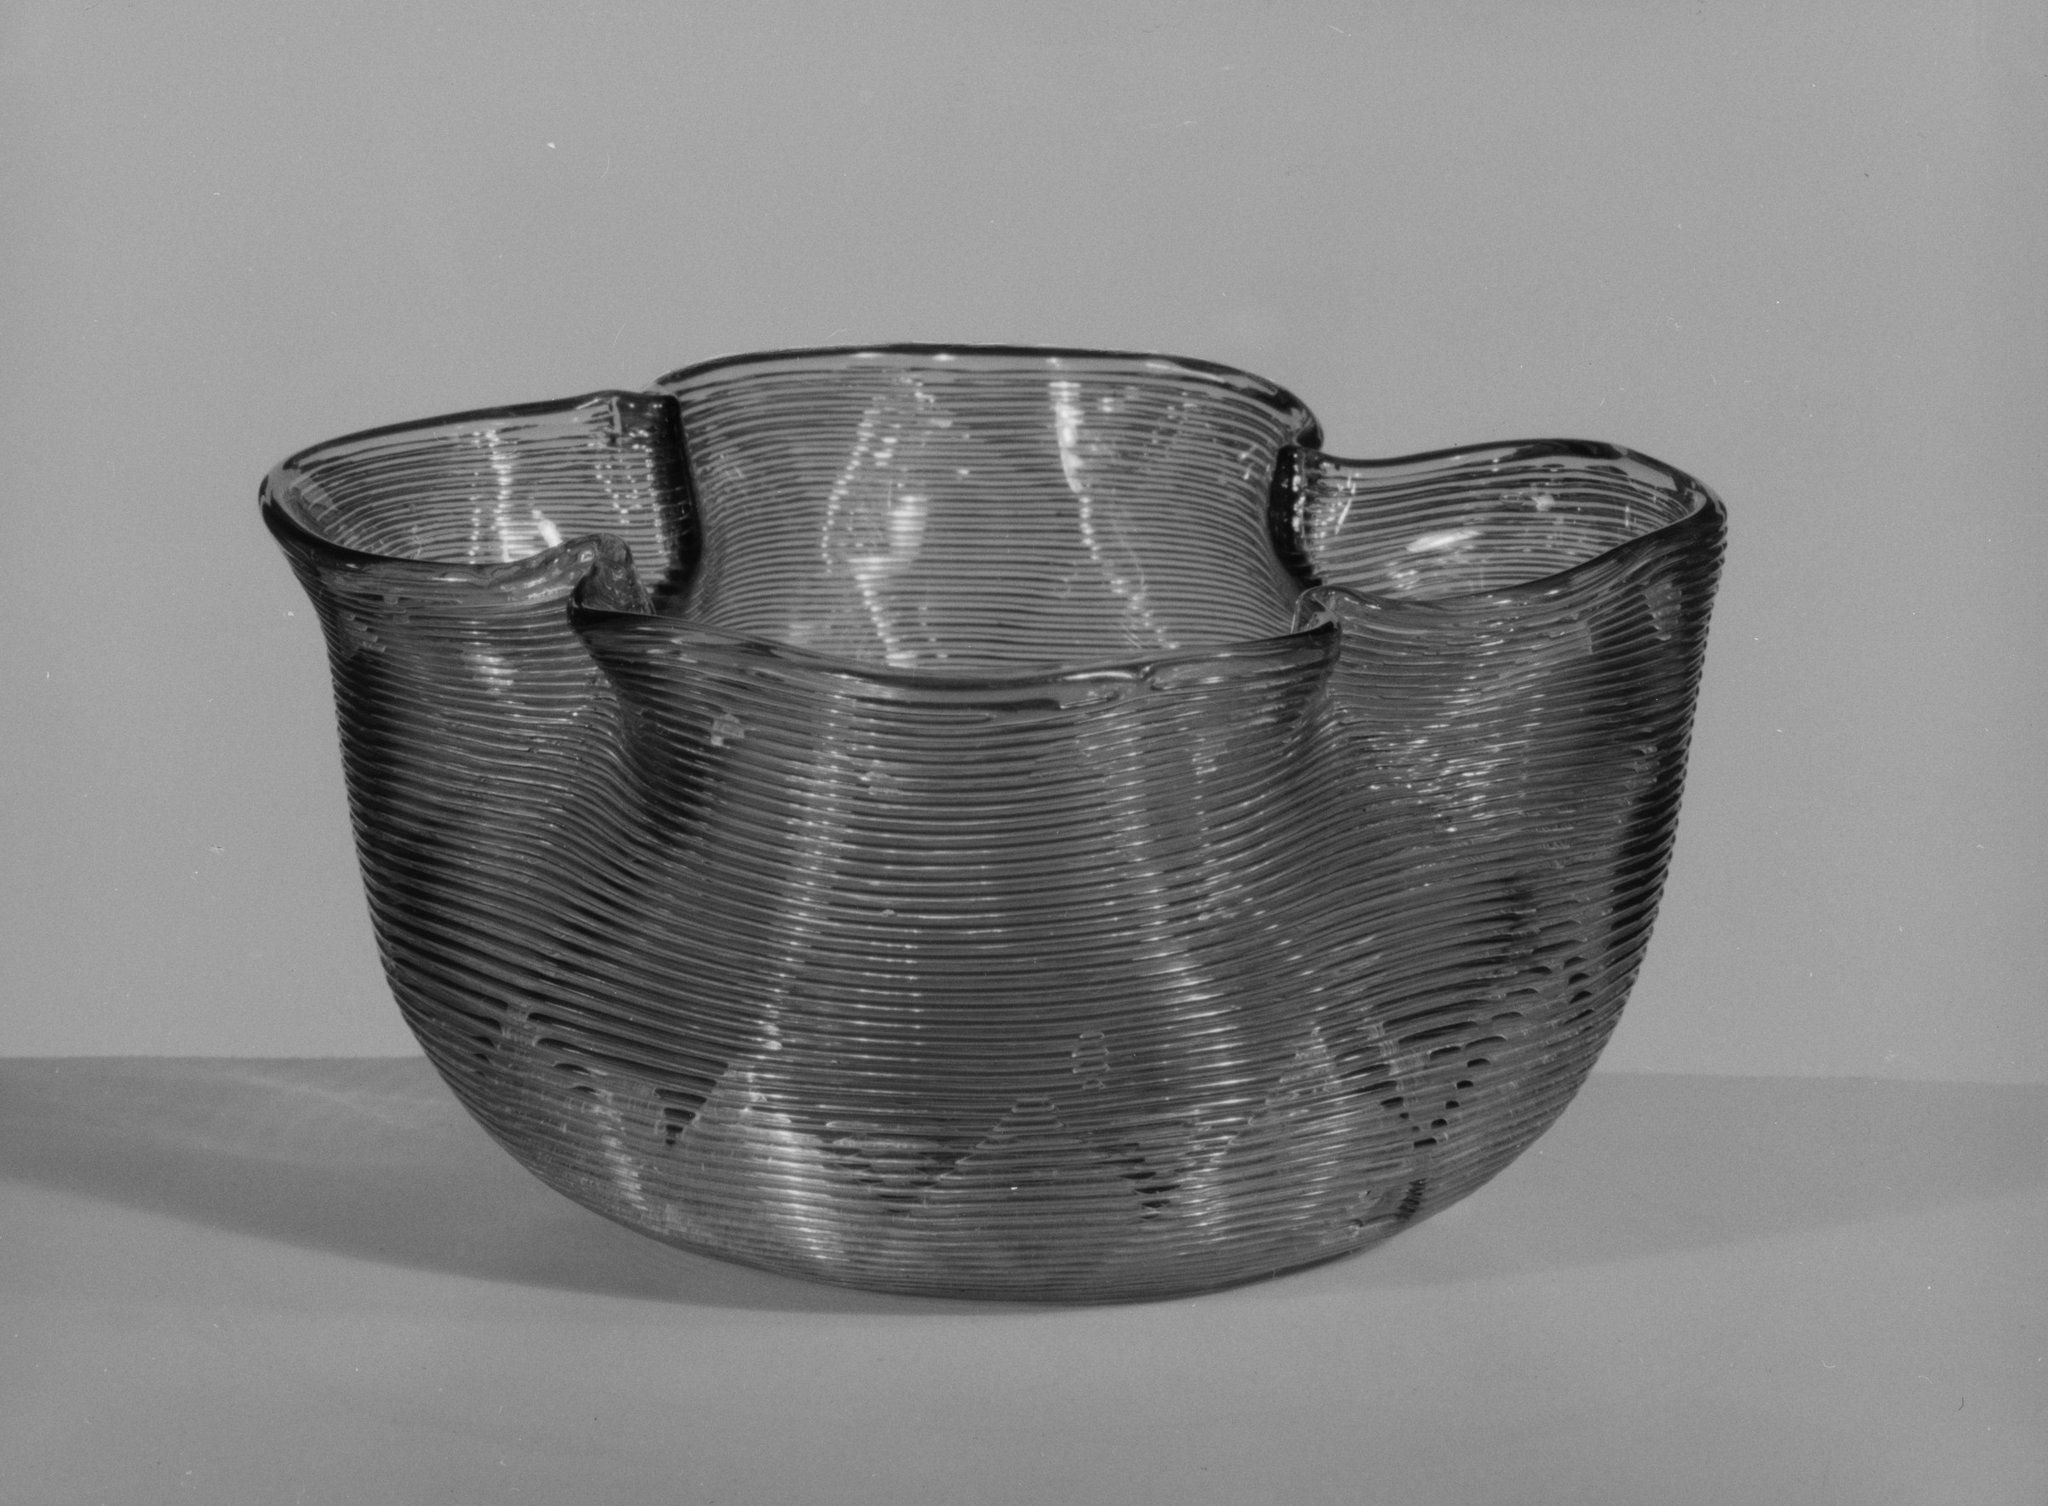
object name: finger bowl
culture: american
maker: boston & sandwich glass company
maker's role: maker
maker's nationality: american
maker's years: 1825-1888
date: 1880-1888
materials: amber, glass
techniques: glassblowing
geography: united states